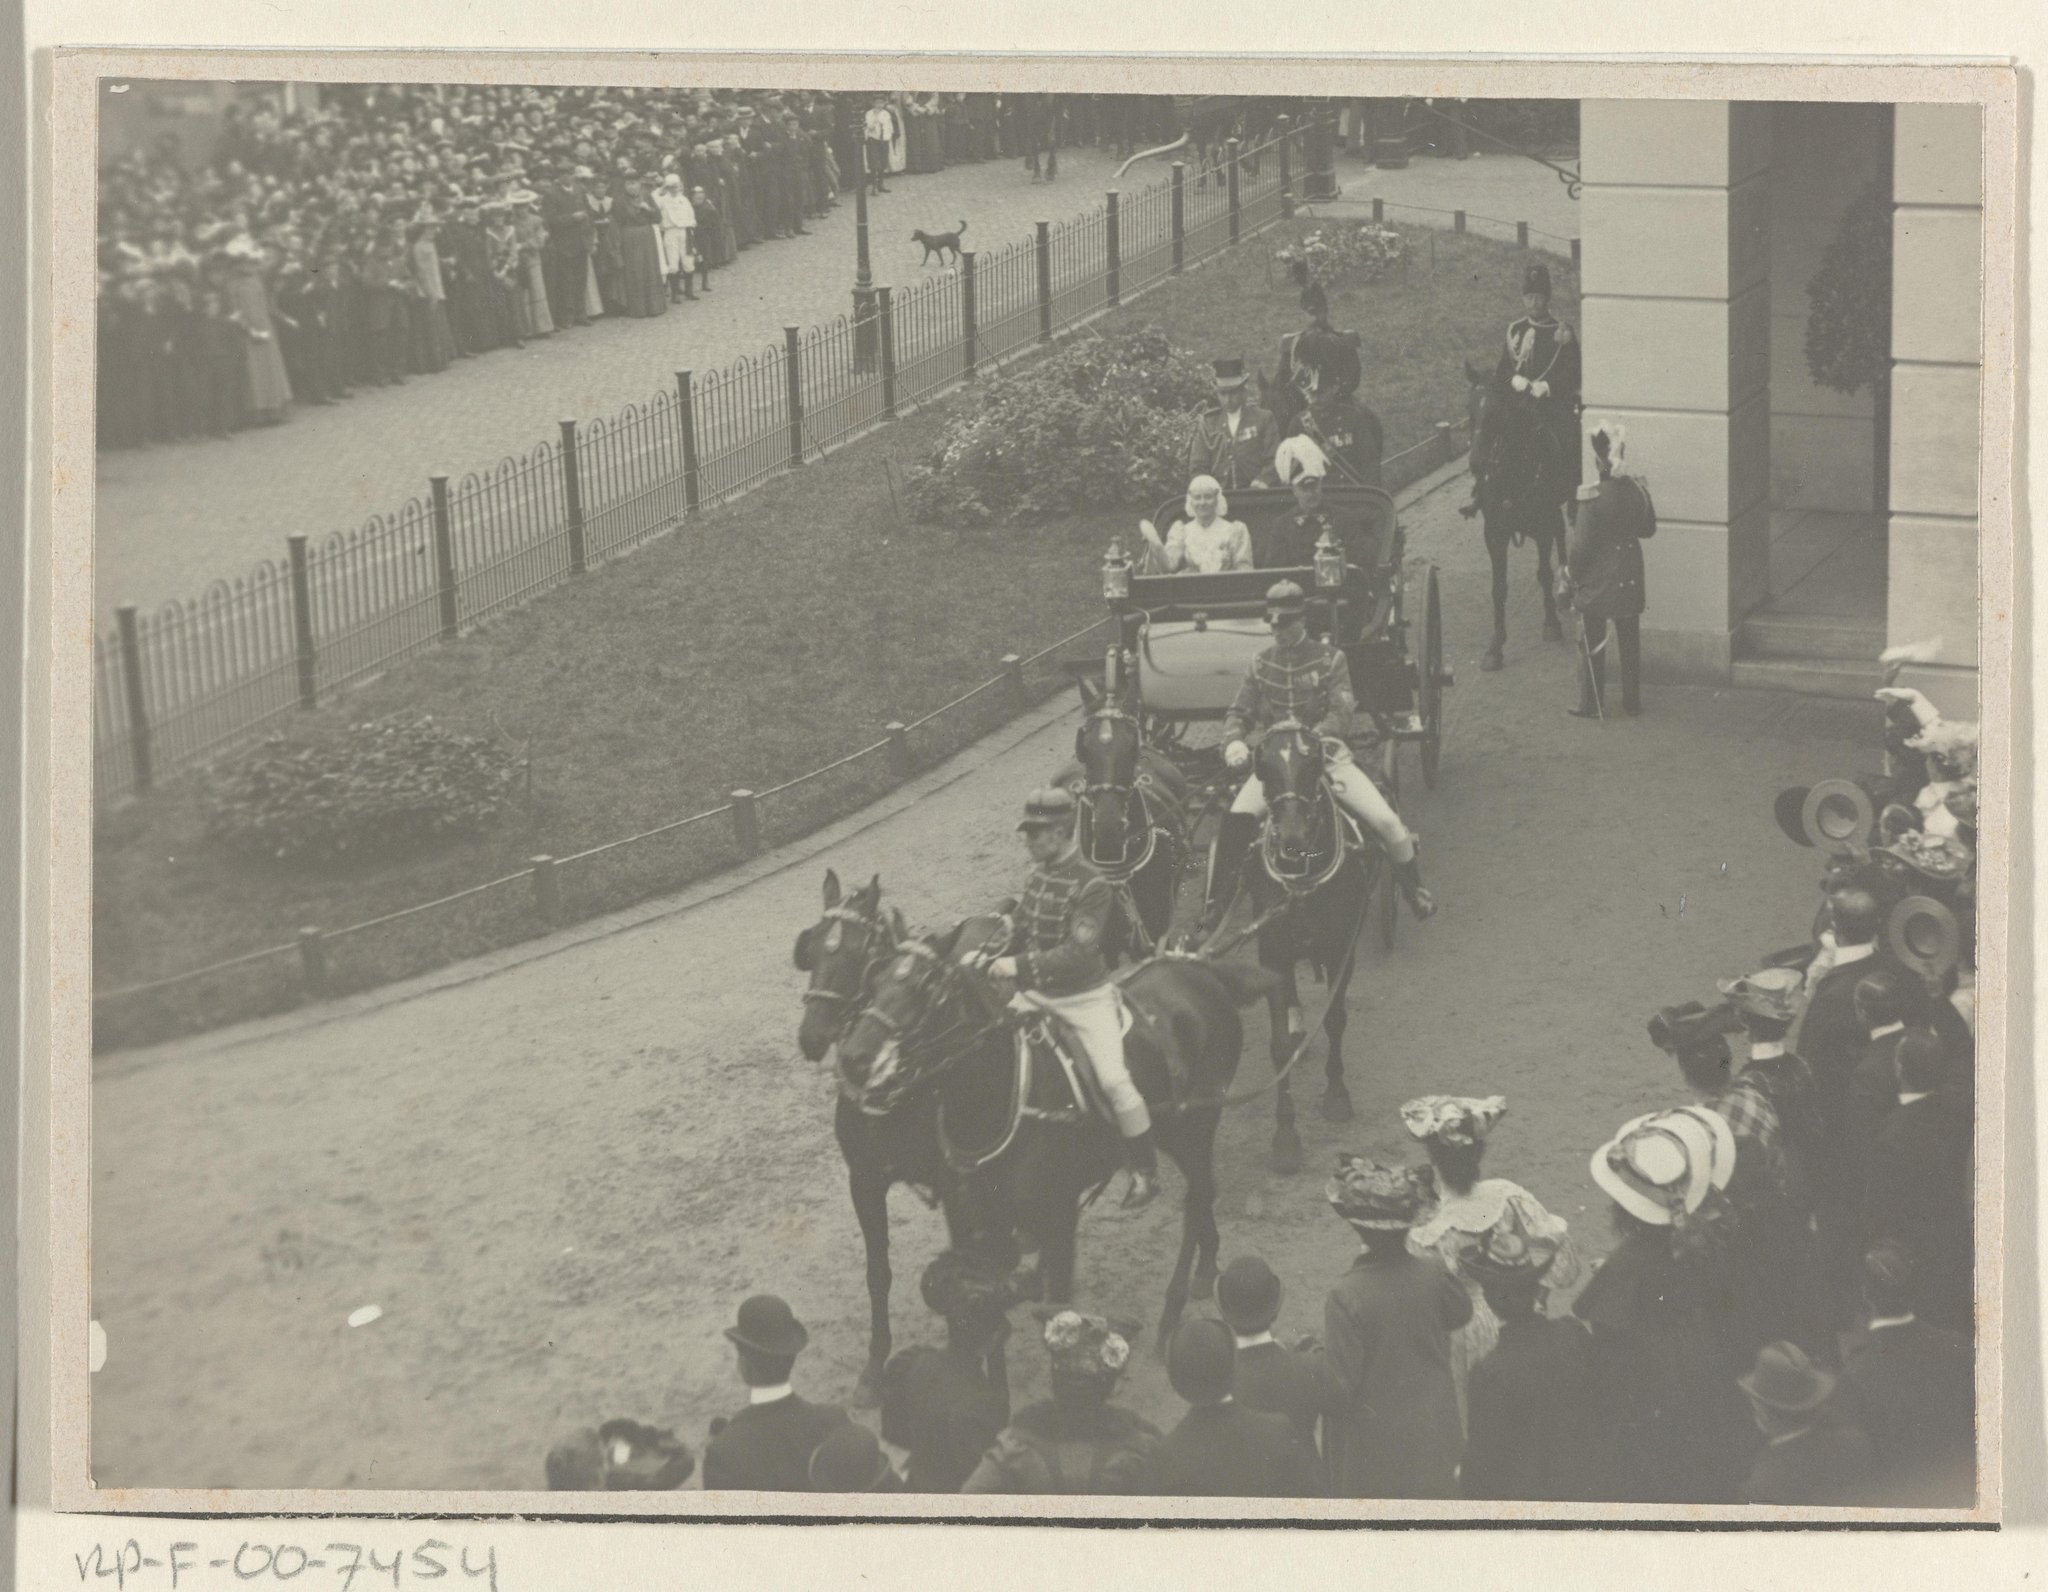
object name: photograph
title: Bezoek van Wilhelmina, koningin der Nederlanden, en Hendrik van Mecklenburg-Schwerin aan Friesland op 22 september 1905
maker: Anonymous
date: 1905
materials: photographic support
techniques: photography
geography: netherlands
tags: print maker, wilhelmina of the netherlands, the hague, hendrik (prins der nederlanden (1876-1934)), animal traction, animal-drawn vehicle (carriage etc.)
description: De hier vermelde titel verwijst naar de hoogst verkregen titel van de geportretteerde, niet per se naar de titel die de geportretteerde op deze voorstelling draagt.